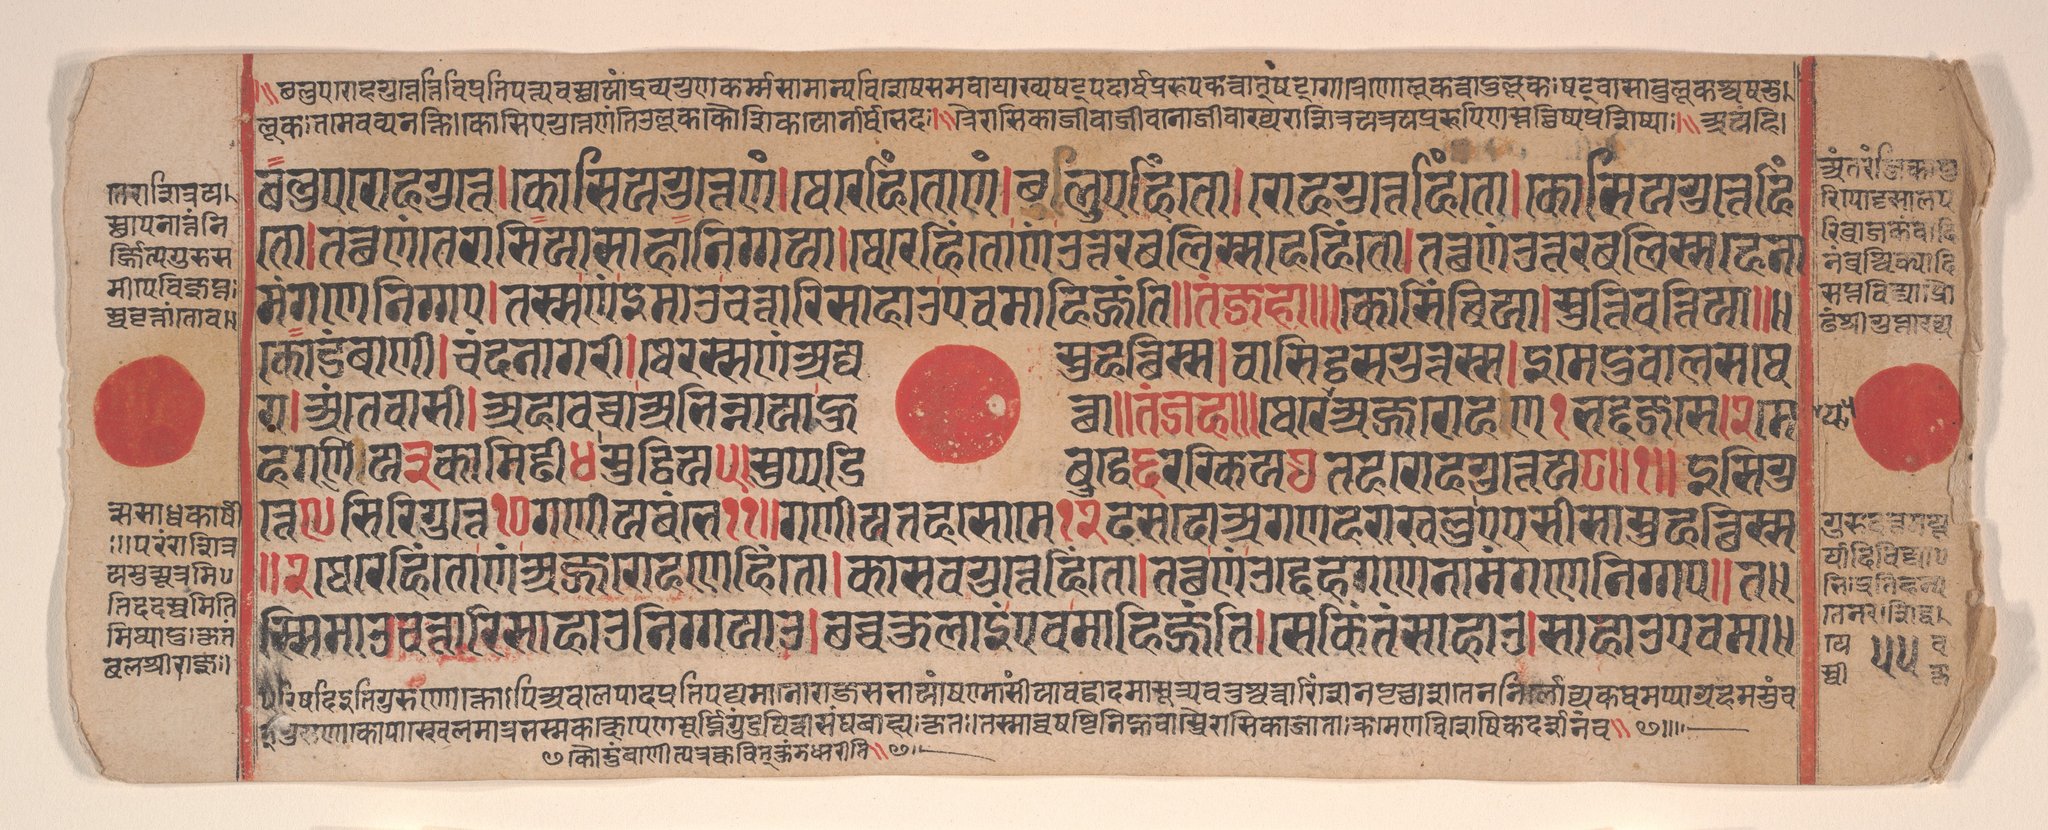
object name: folio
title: Leaf from a Kalpa Sutra (Jain Book of Rituals)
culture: indian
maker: bhadrabahu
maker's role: artist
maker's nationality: indian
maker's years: 356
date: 1401-1500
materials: gold, ink, paper, watercolor